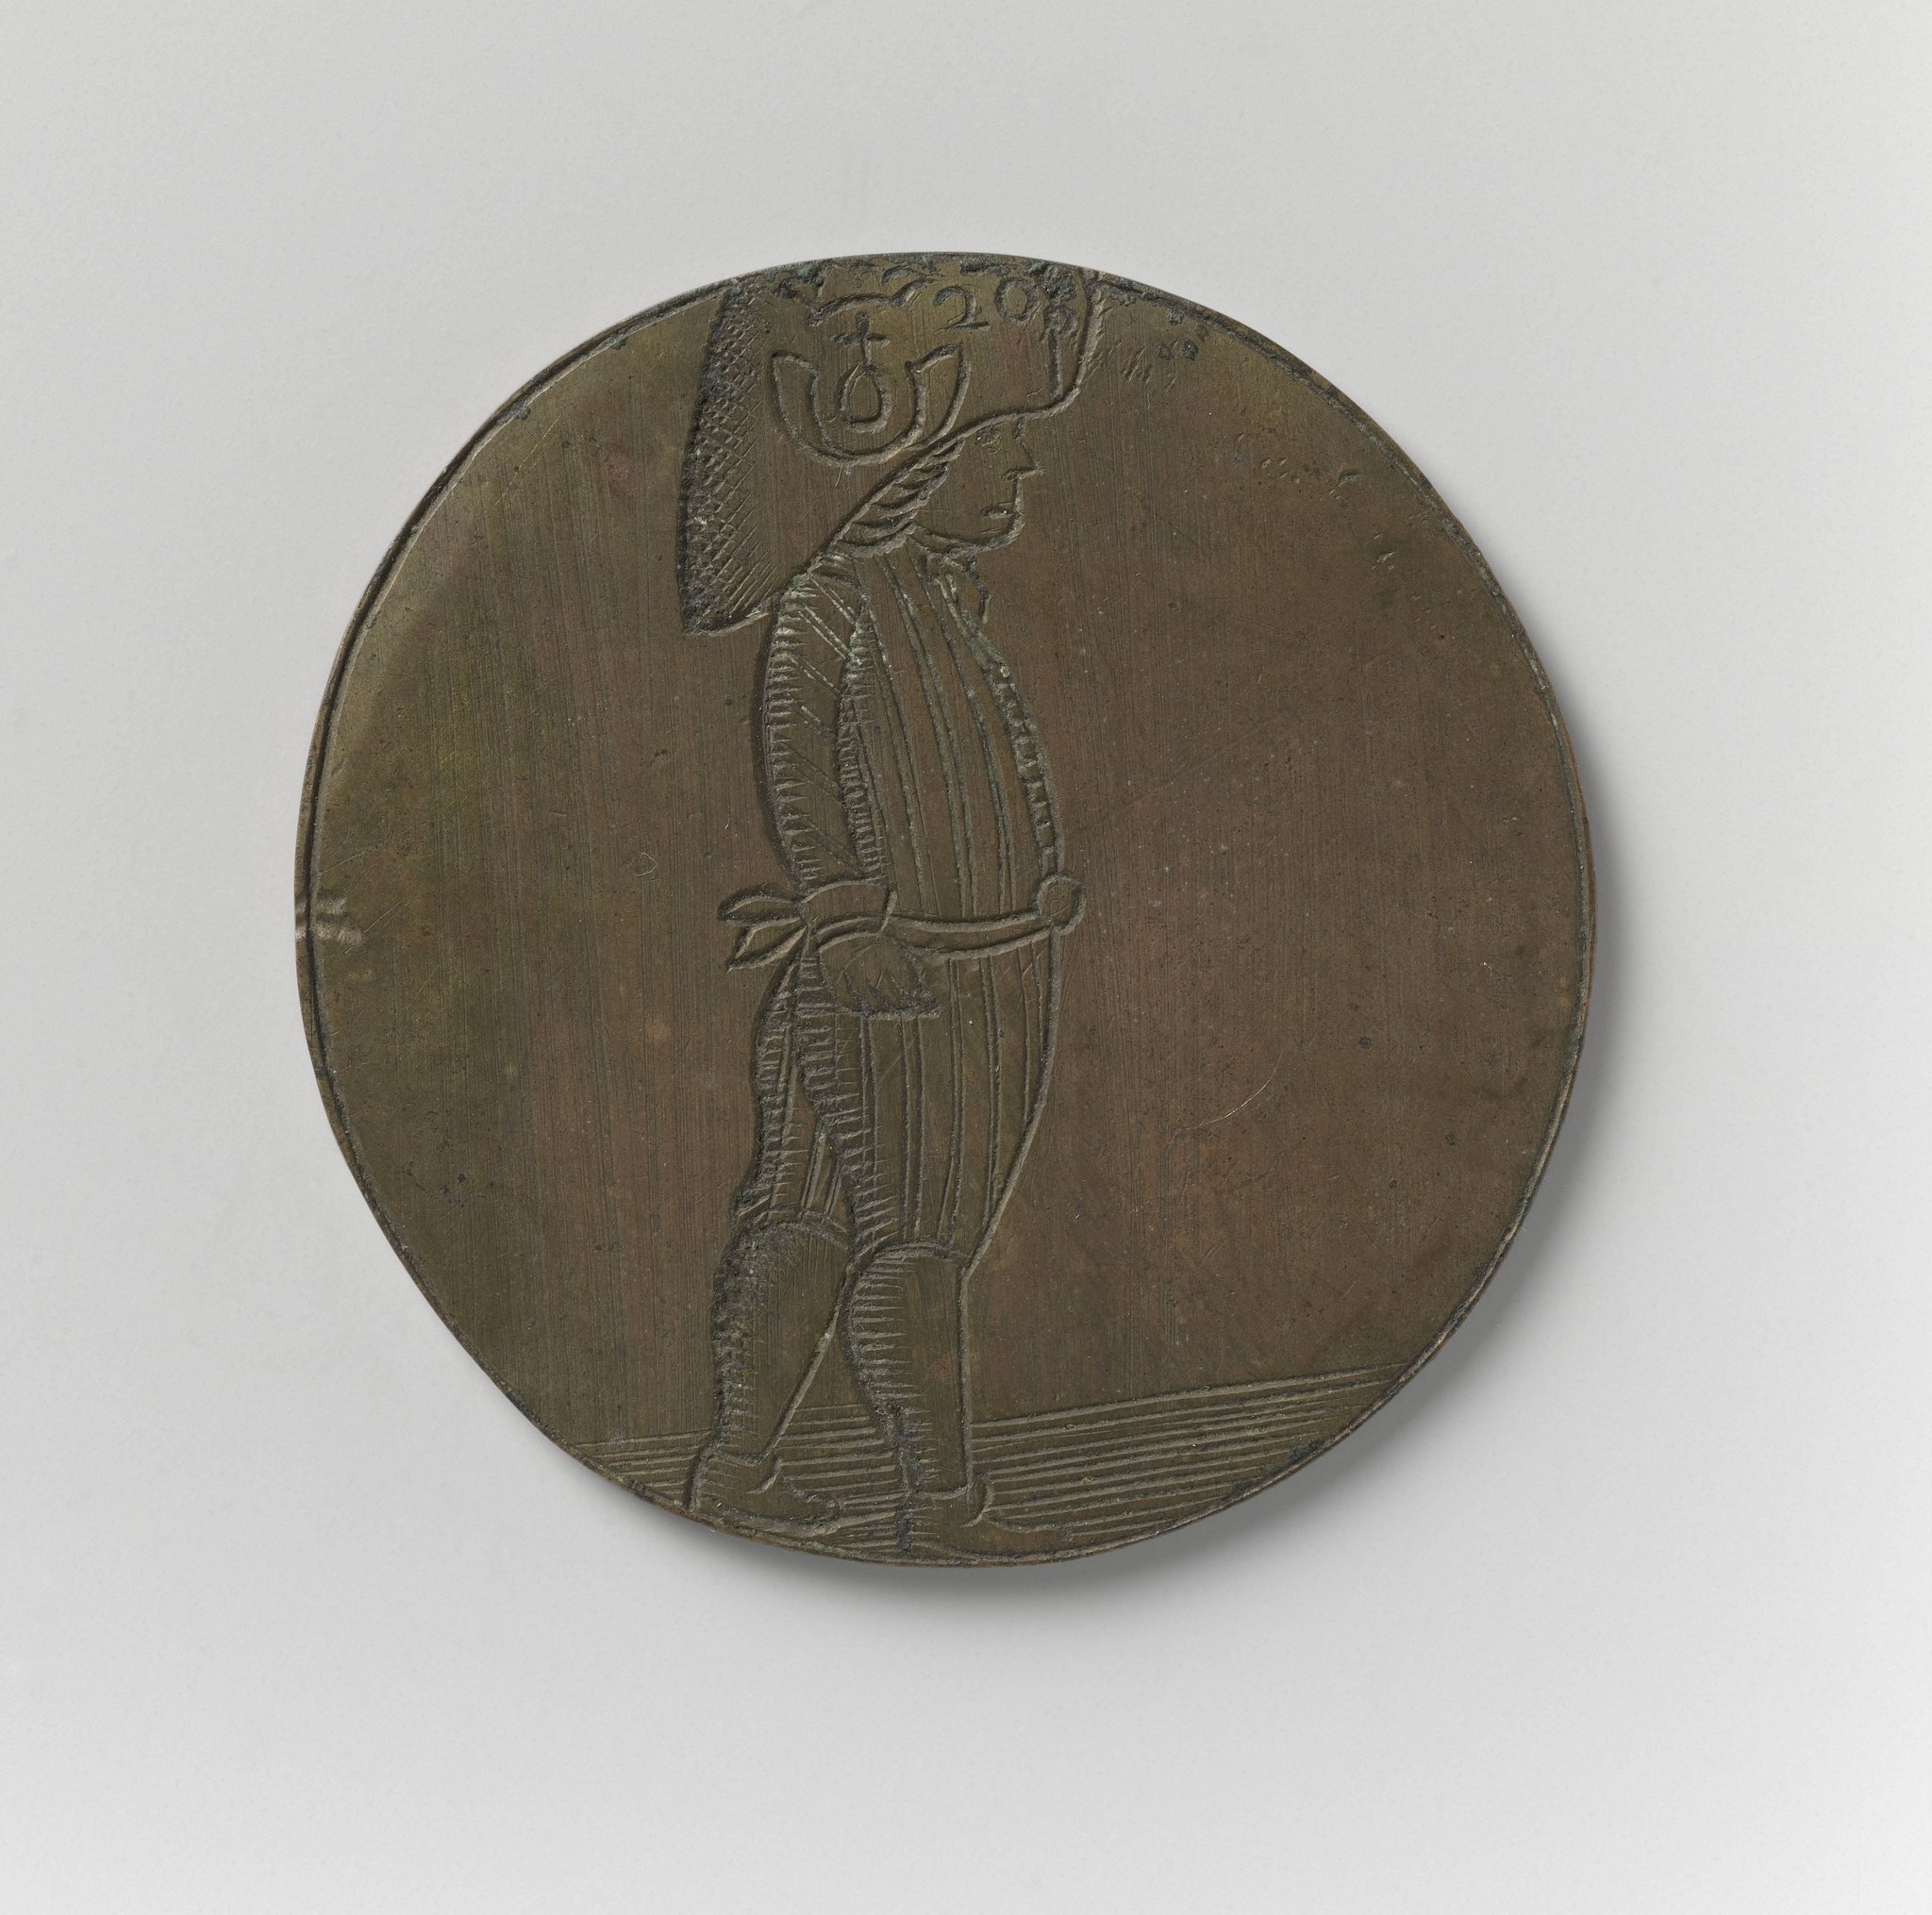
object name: medal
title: Korendragers- en -stortersgilde van Amsterdam, gildepenning van Jacob Hofman uit Amsterdam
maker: Anonymous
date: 1720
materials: copper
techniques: engraving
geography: amsterdam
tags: amsterdam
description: Koperen penning. Voorzijde: naar rechts gewende man met last op hoofd; daarop cijfer 20. Keerzijde: opschrift